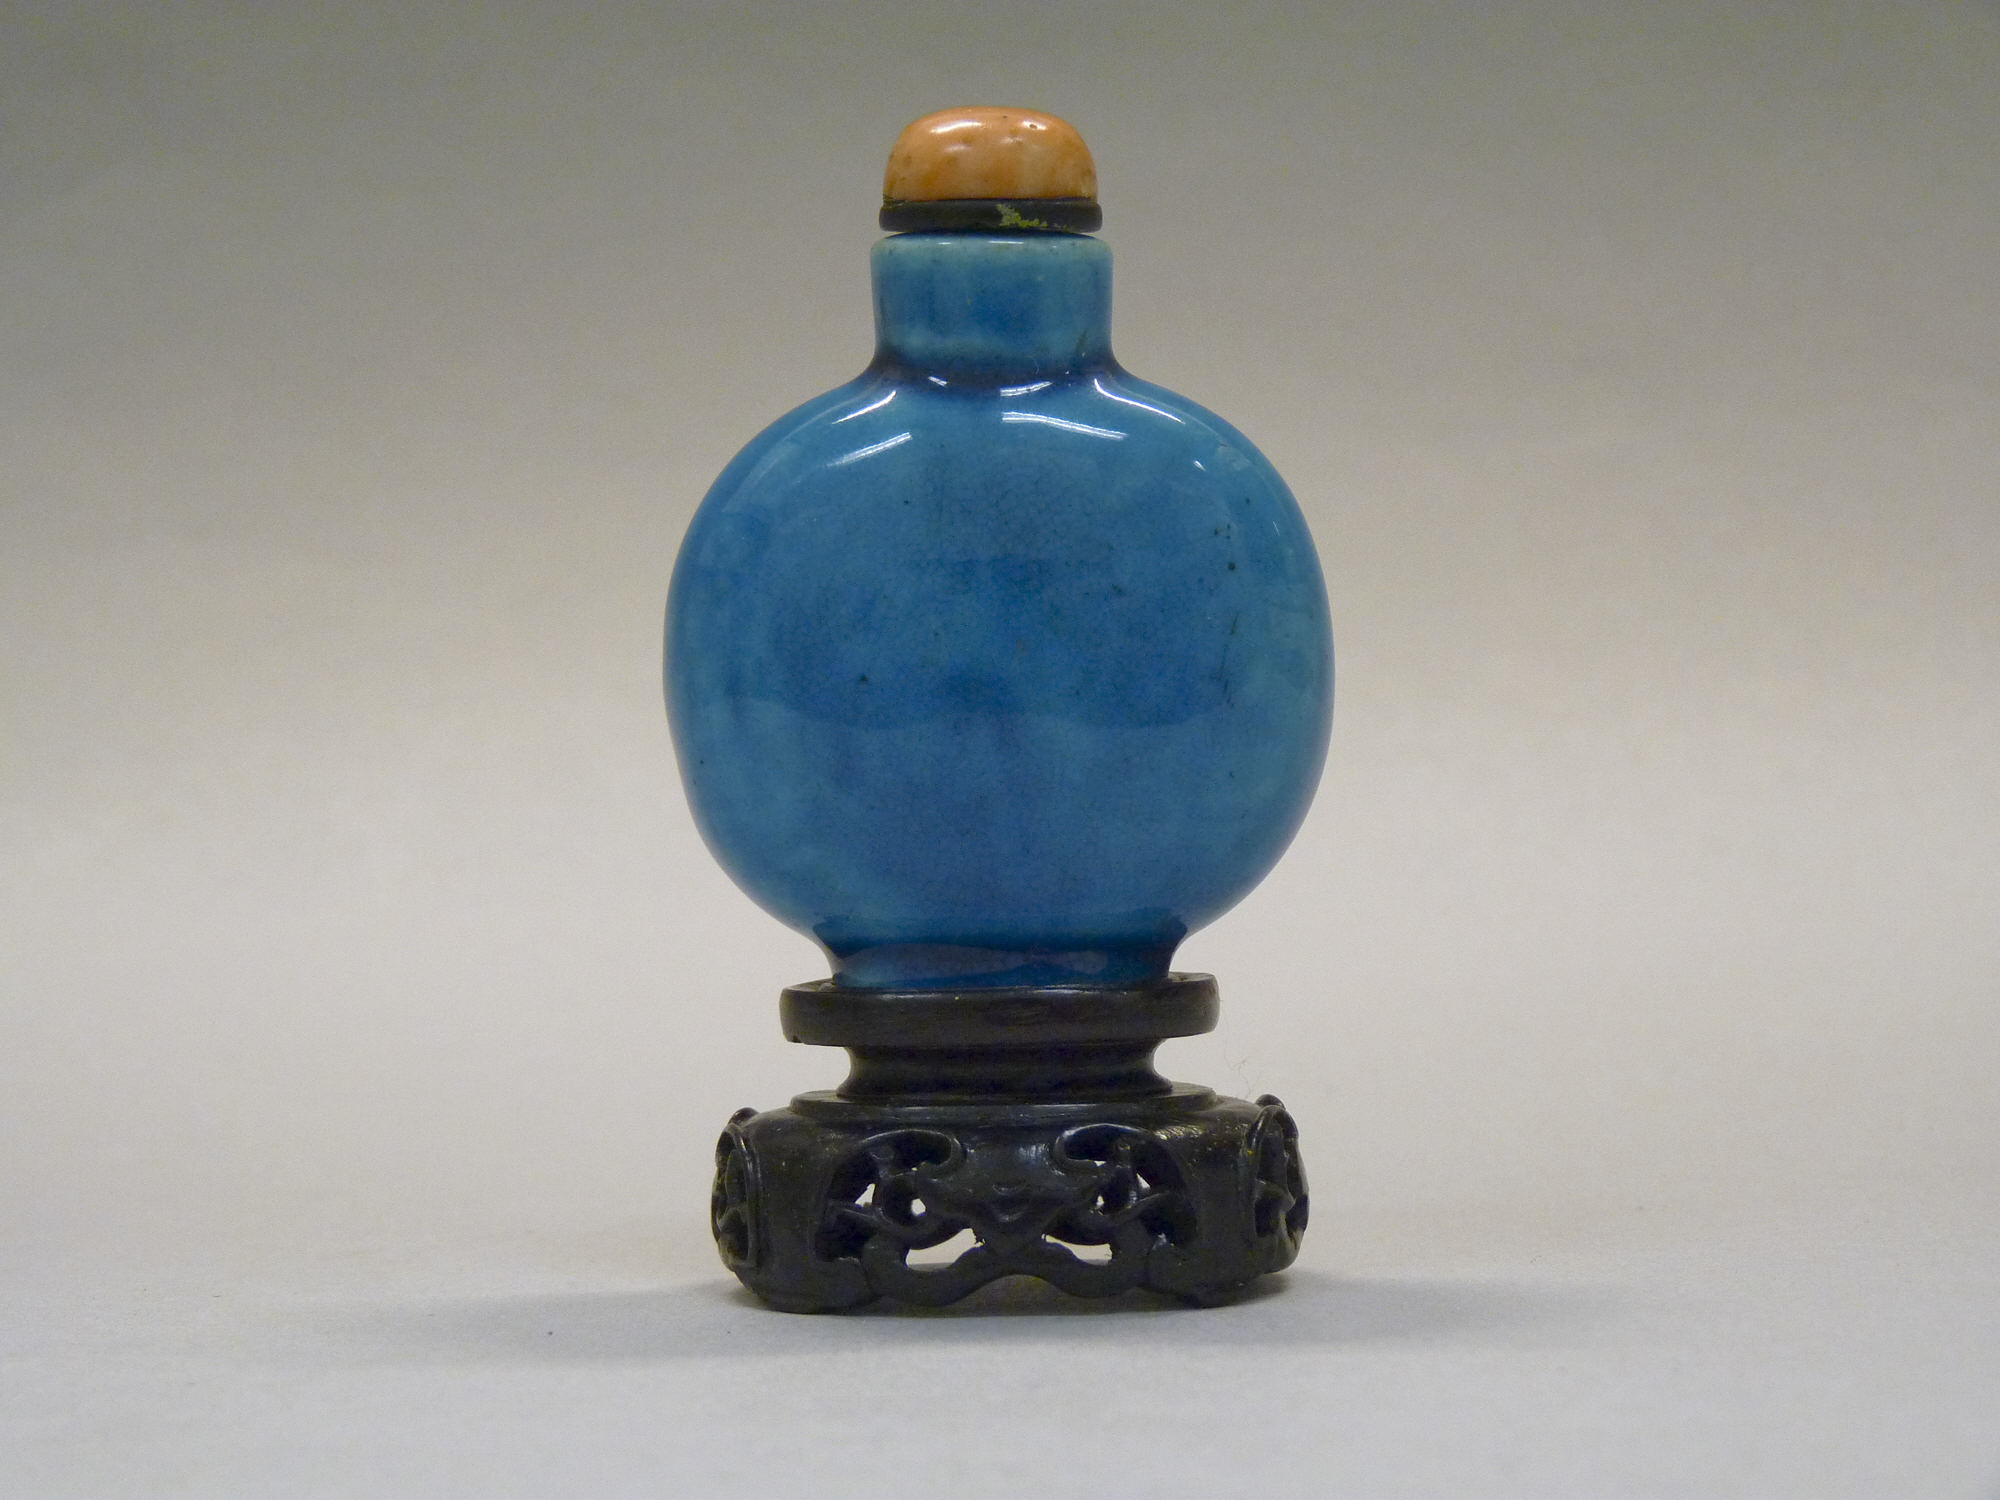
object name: snuff bottle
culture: chinese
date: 1736-1795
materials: coral, porcelain